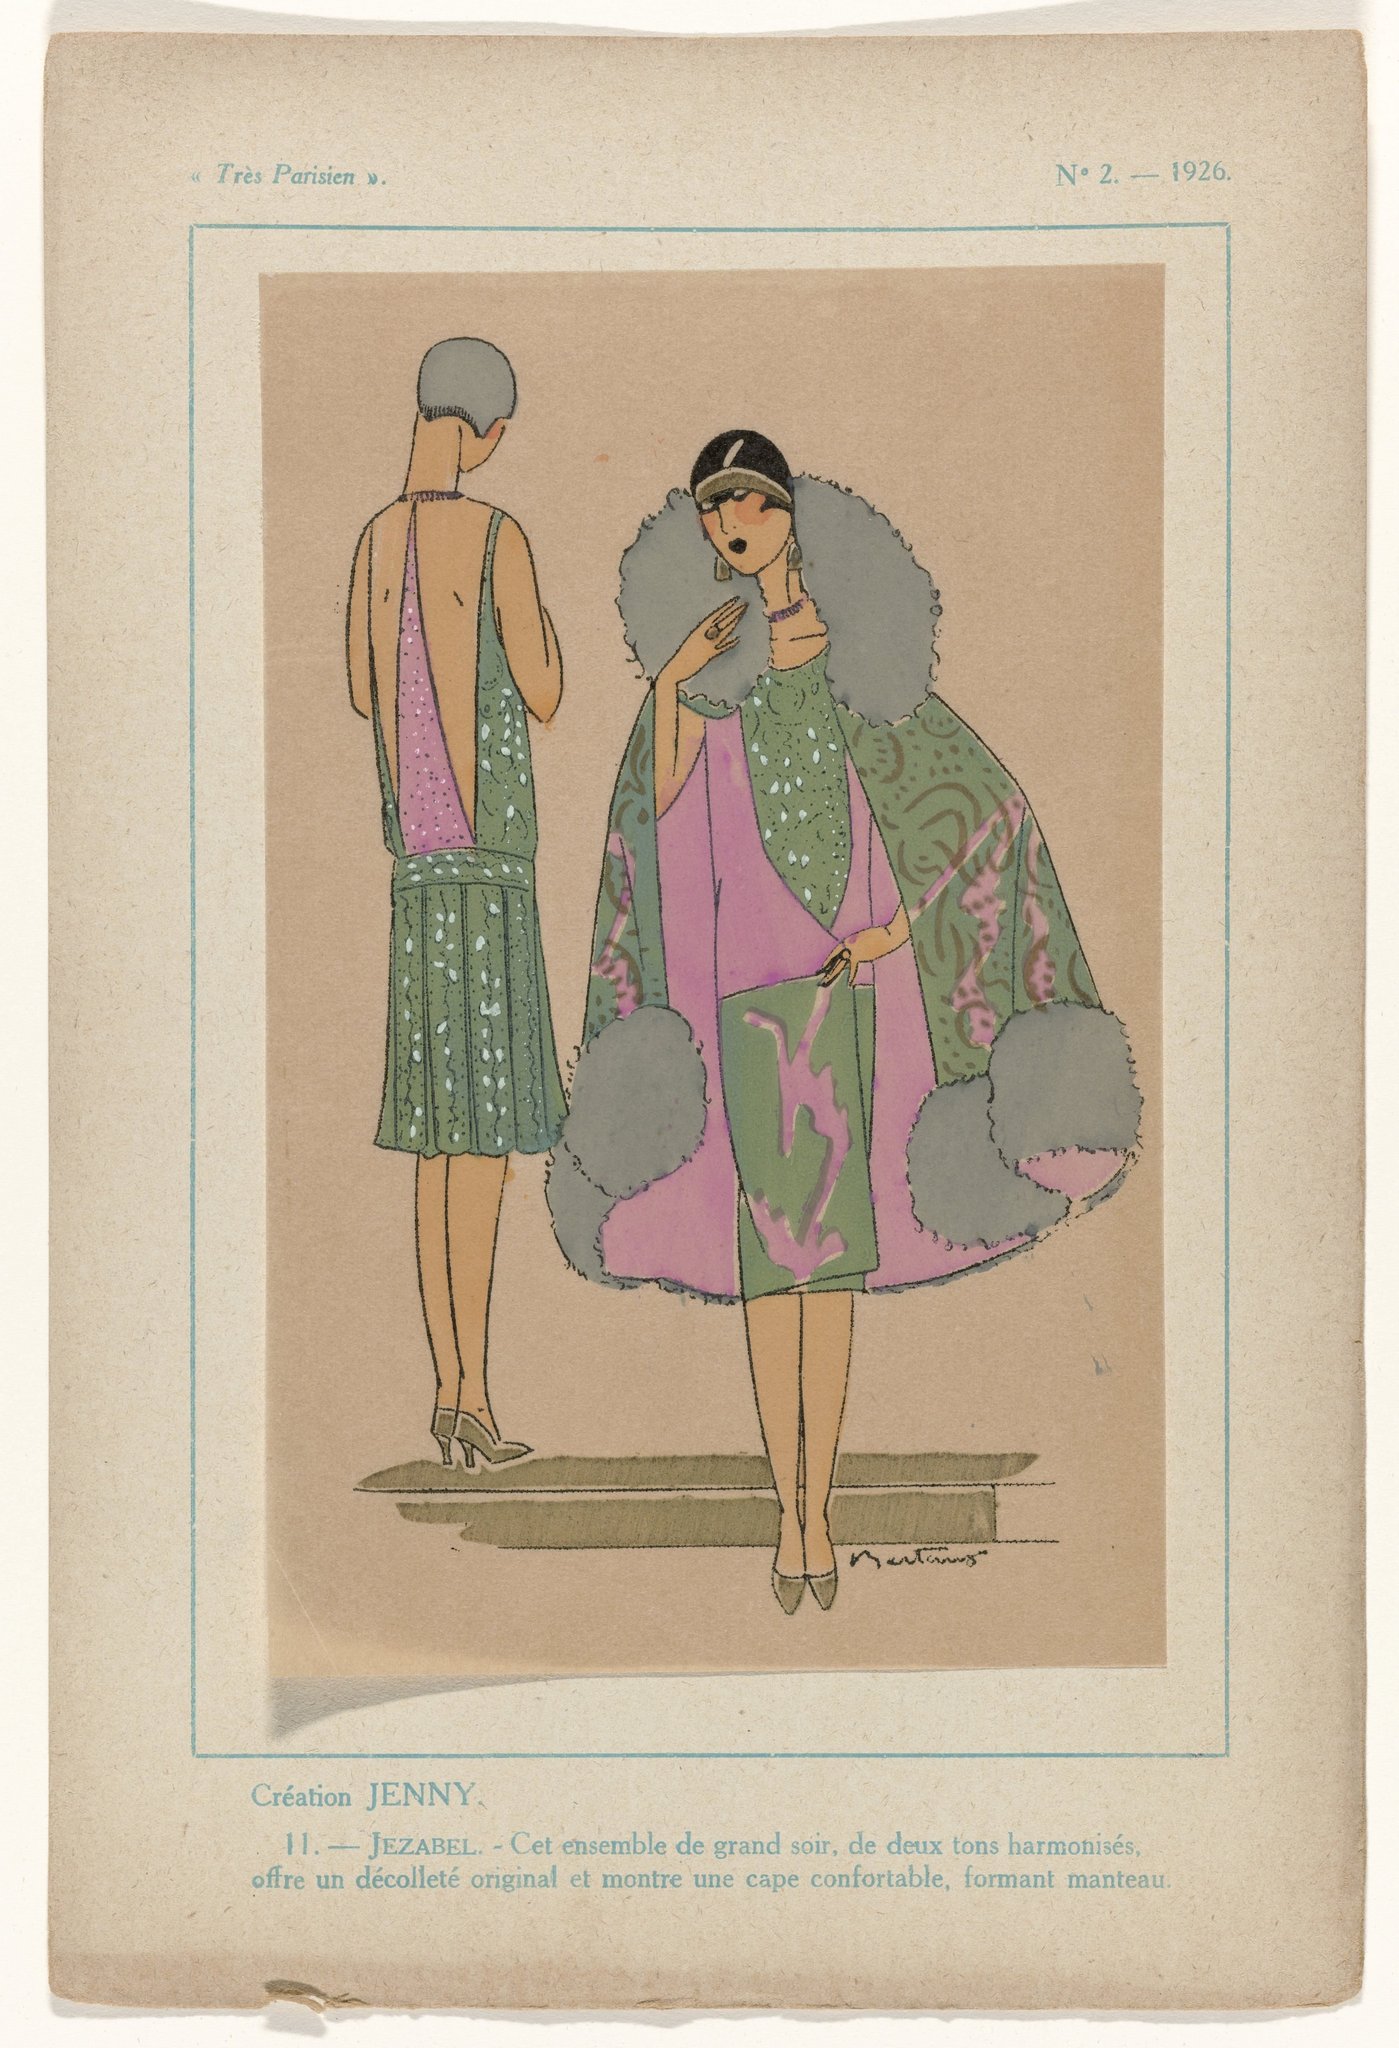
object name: fashion print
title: Très Parisien, 1926, No 2, Pl. 11: Création JENNY - JEZABEL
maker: g-p. joumard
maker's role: publisher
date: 1926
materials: paper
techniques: hand coloring, letterpress printing, lithography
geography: paris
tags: dress, gown: evening dress (+ women's clothes), coat (evening coat) (+ women's clothes), fashion plates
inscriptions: caption: ‘JEZABEL. - Cet ensemble de grand soir, de deux tons harmonisés, offre un decolleté original et montre une cape confortable, formant manteau.’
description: Ensemble bestaande uit een avondjurkje en een avondcape in roze en groen van modehuis Jenny. Prent uit het modetijdschrift Très Parisien...La Mode, Le Chic, L'Élégance (1920-1936)